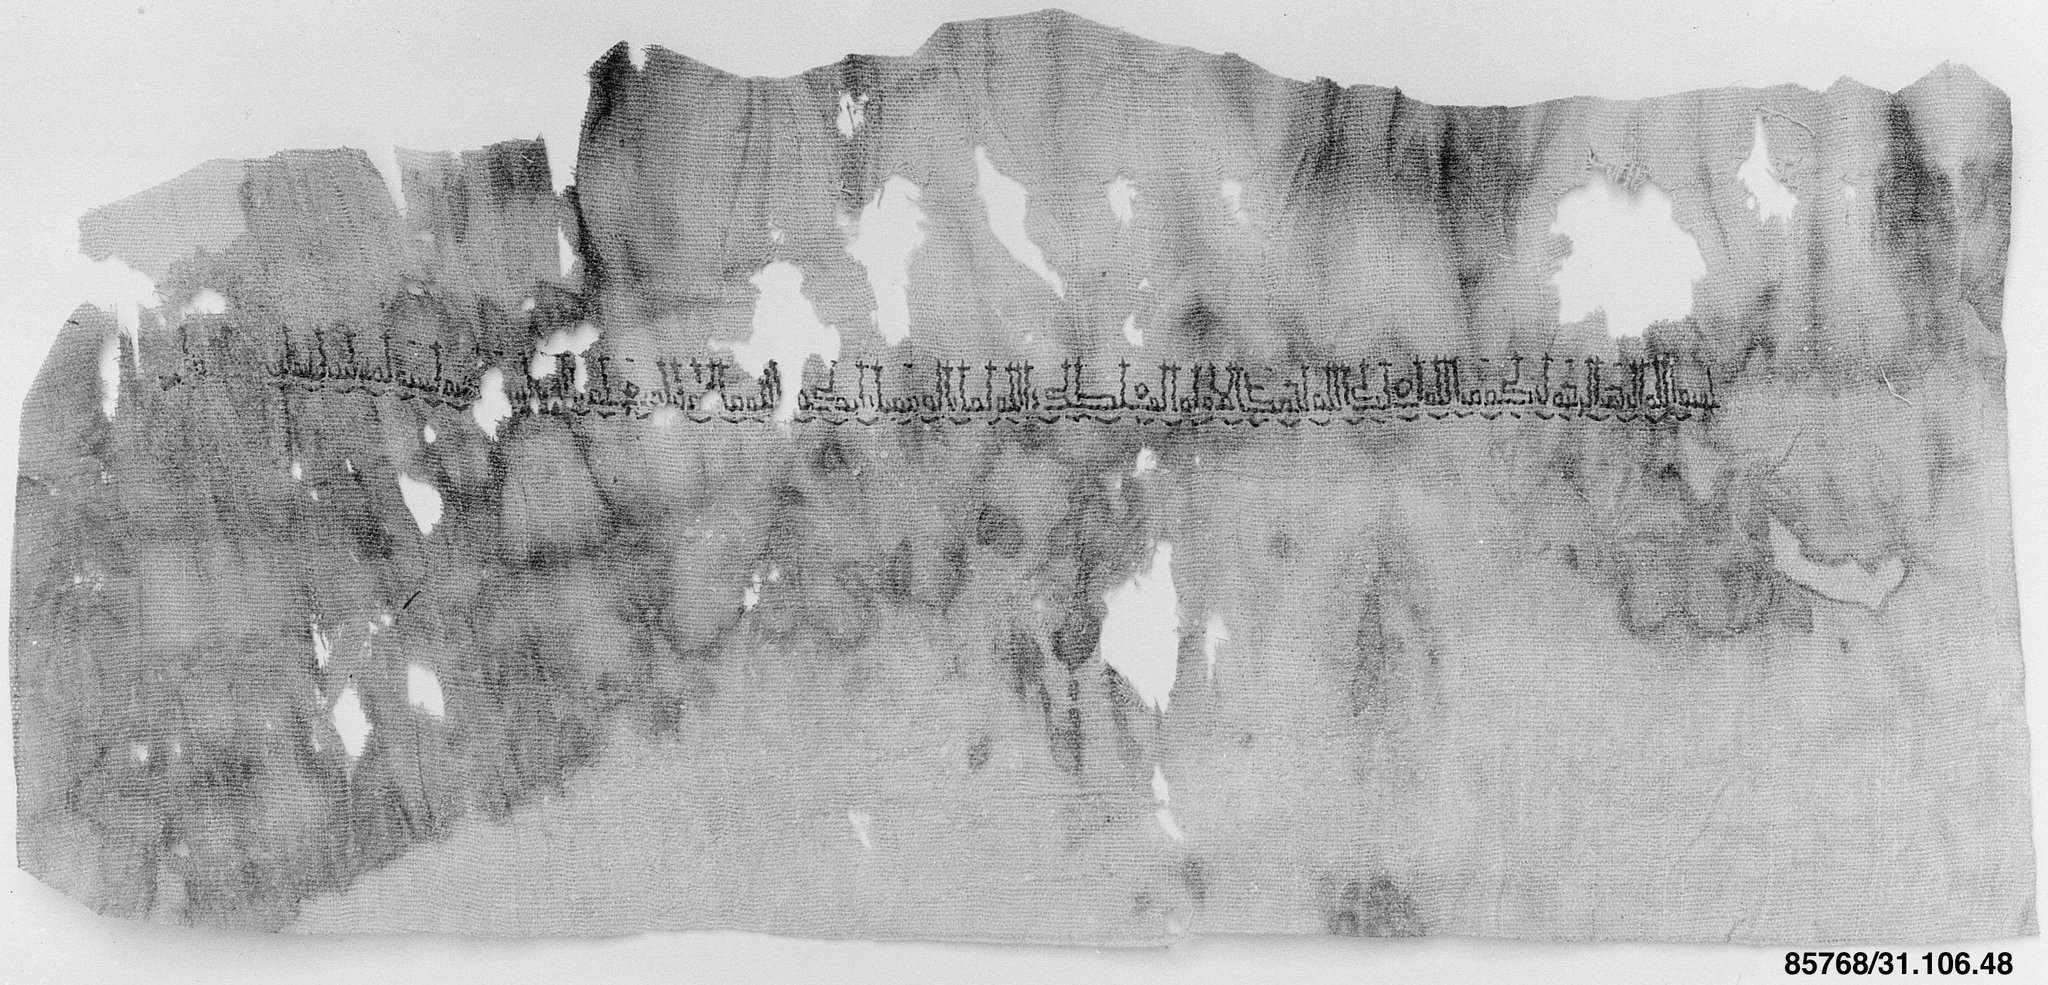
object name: fragment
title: Textile Fragment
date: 892-902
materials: linen, silk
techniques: embroidery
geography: egypt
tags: arabic